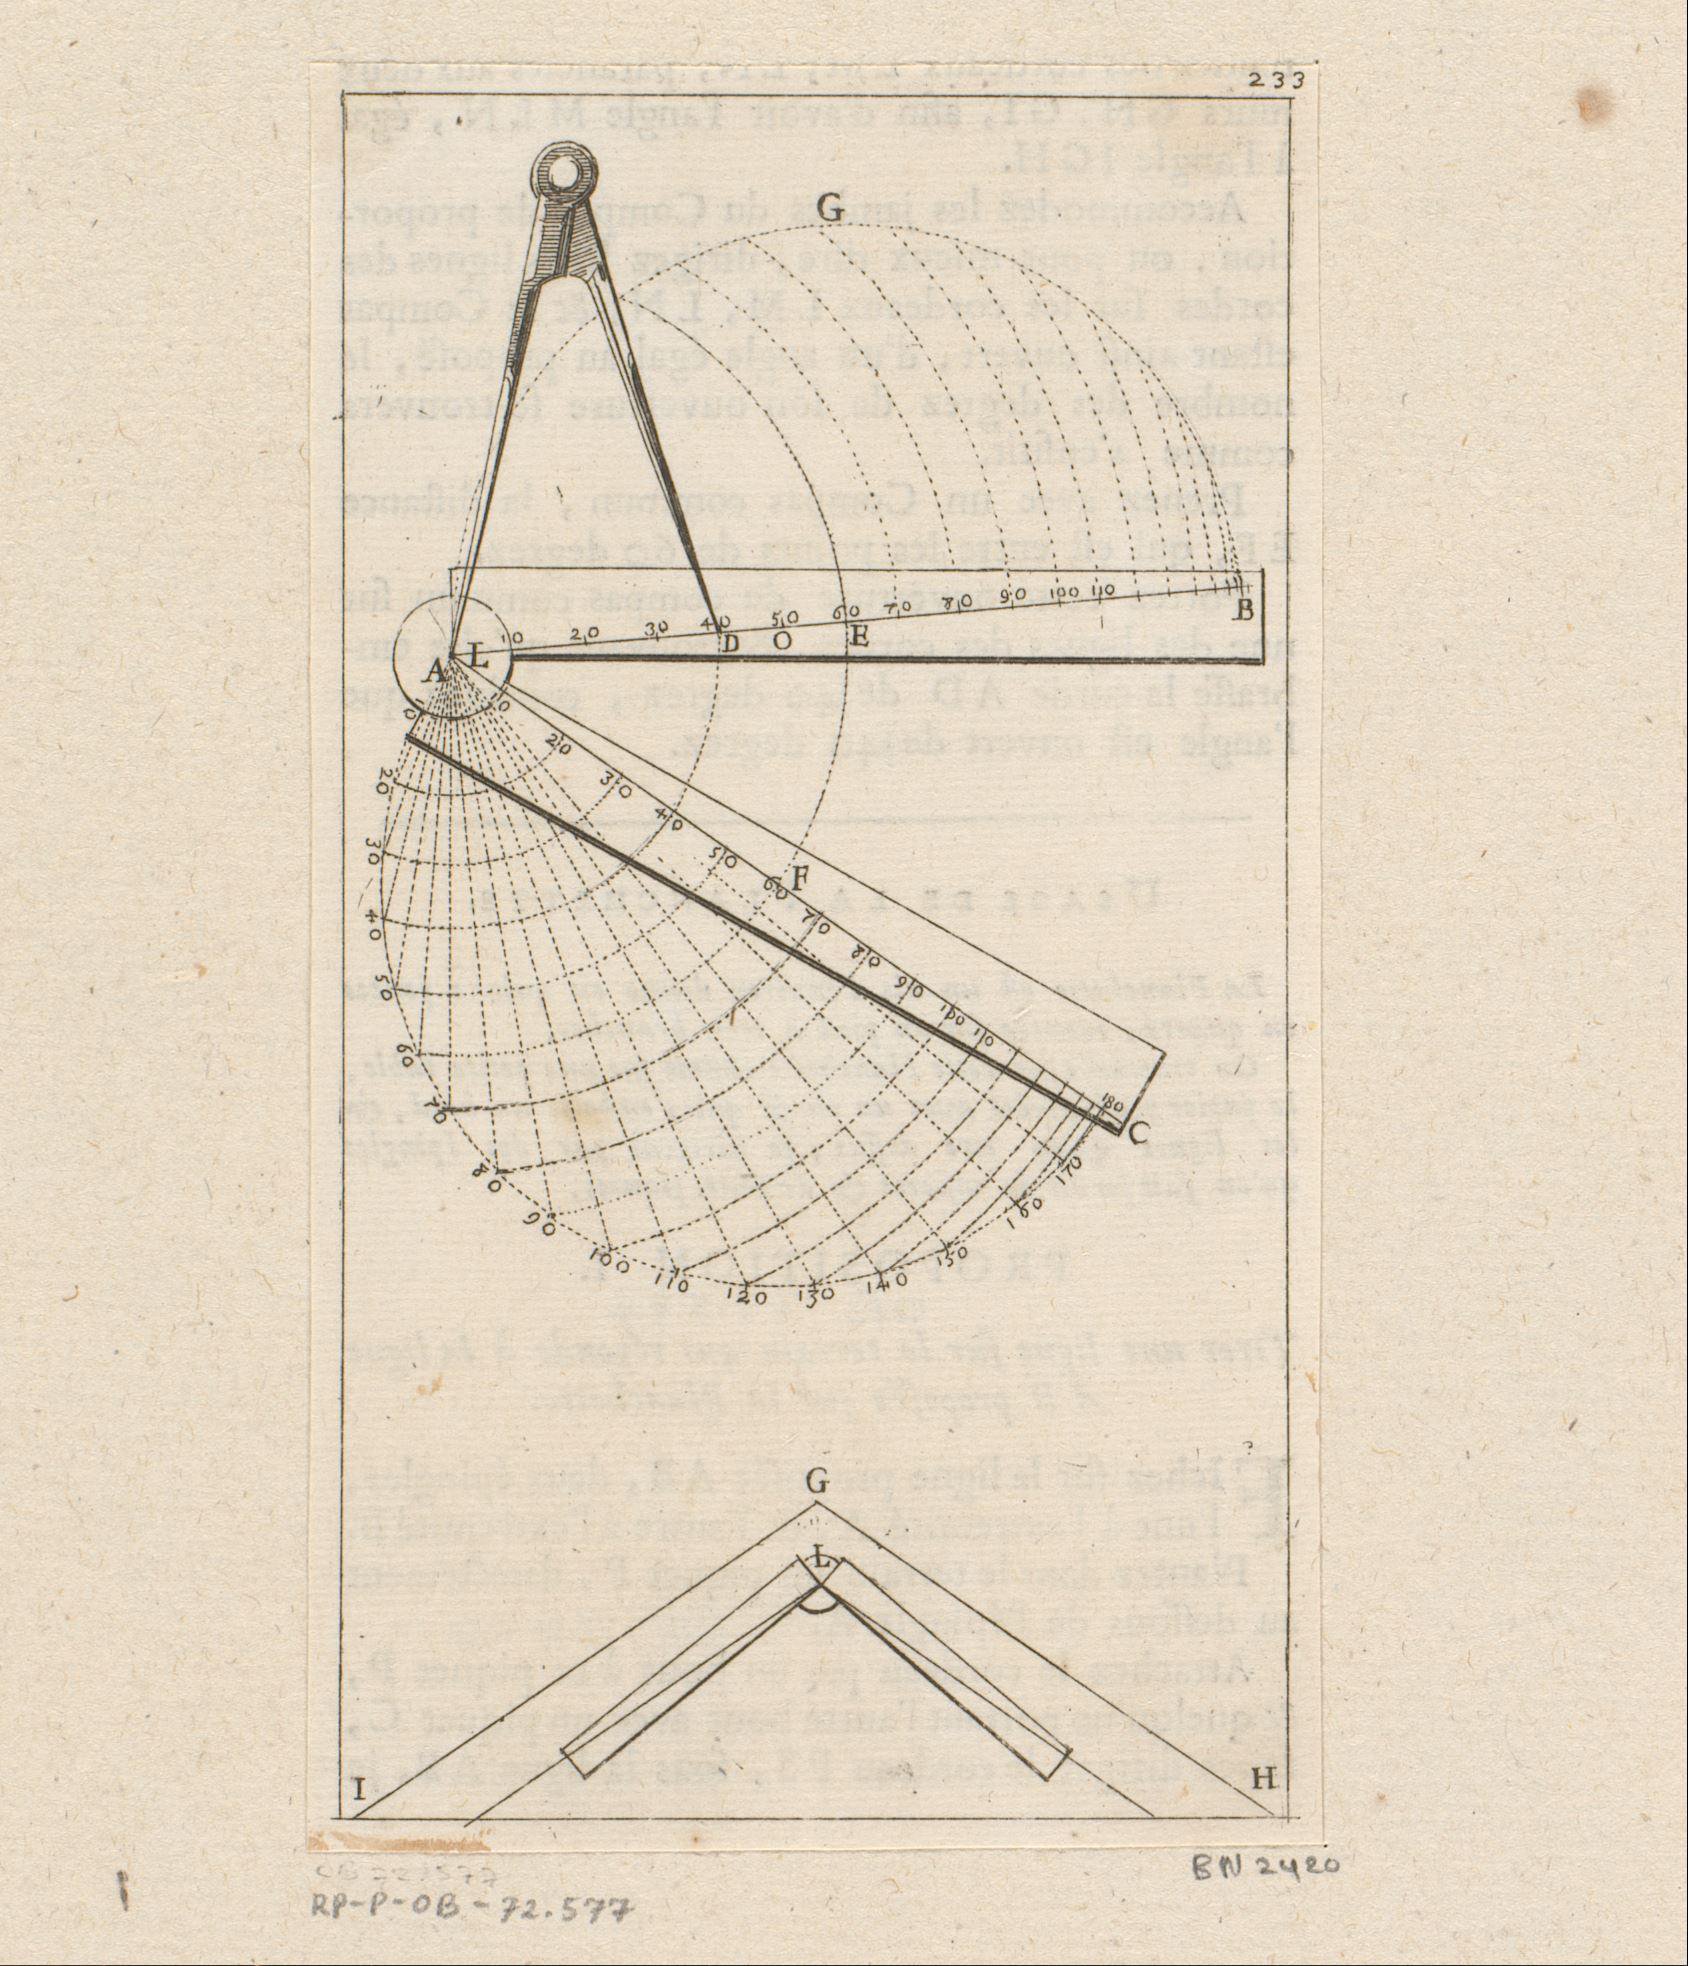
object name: print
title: Gebruik van de passer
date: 1690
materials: paper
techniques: etching, letterpress printing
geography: paris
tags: compasses, planimetry, geometry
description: Prent uit: Leclerc, Sébastien. Traité de géométrie (...). Parijs: Jean Jombert, 1690.